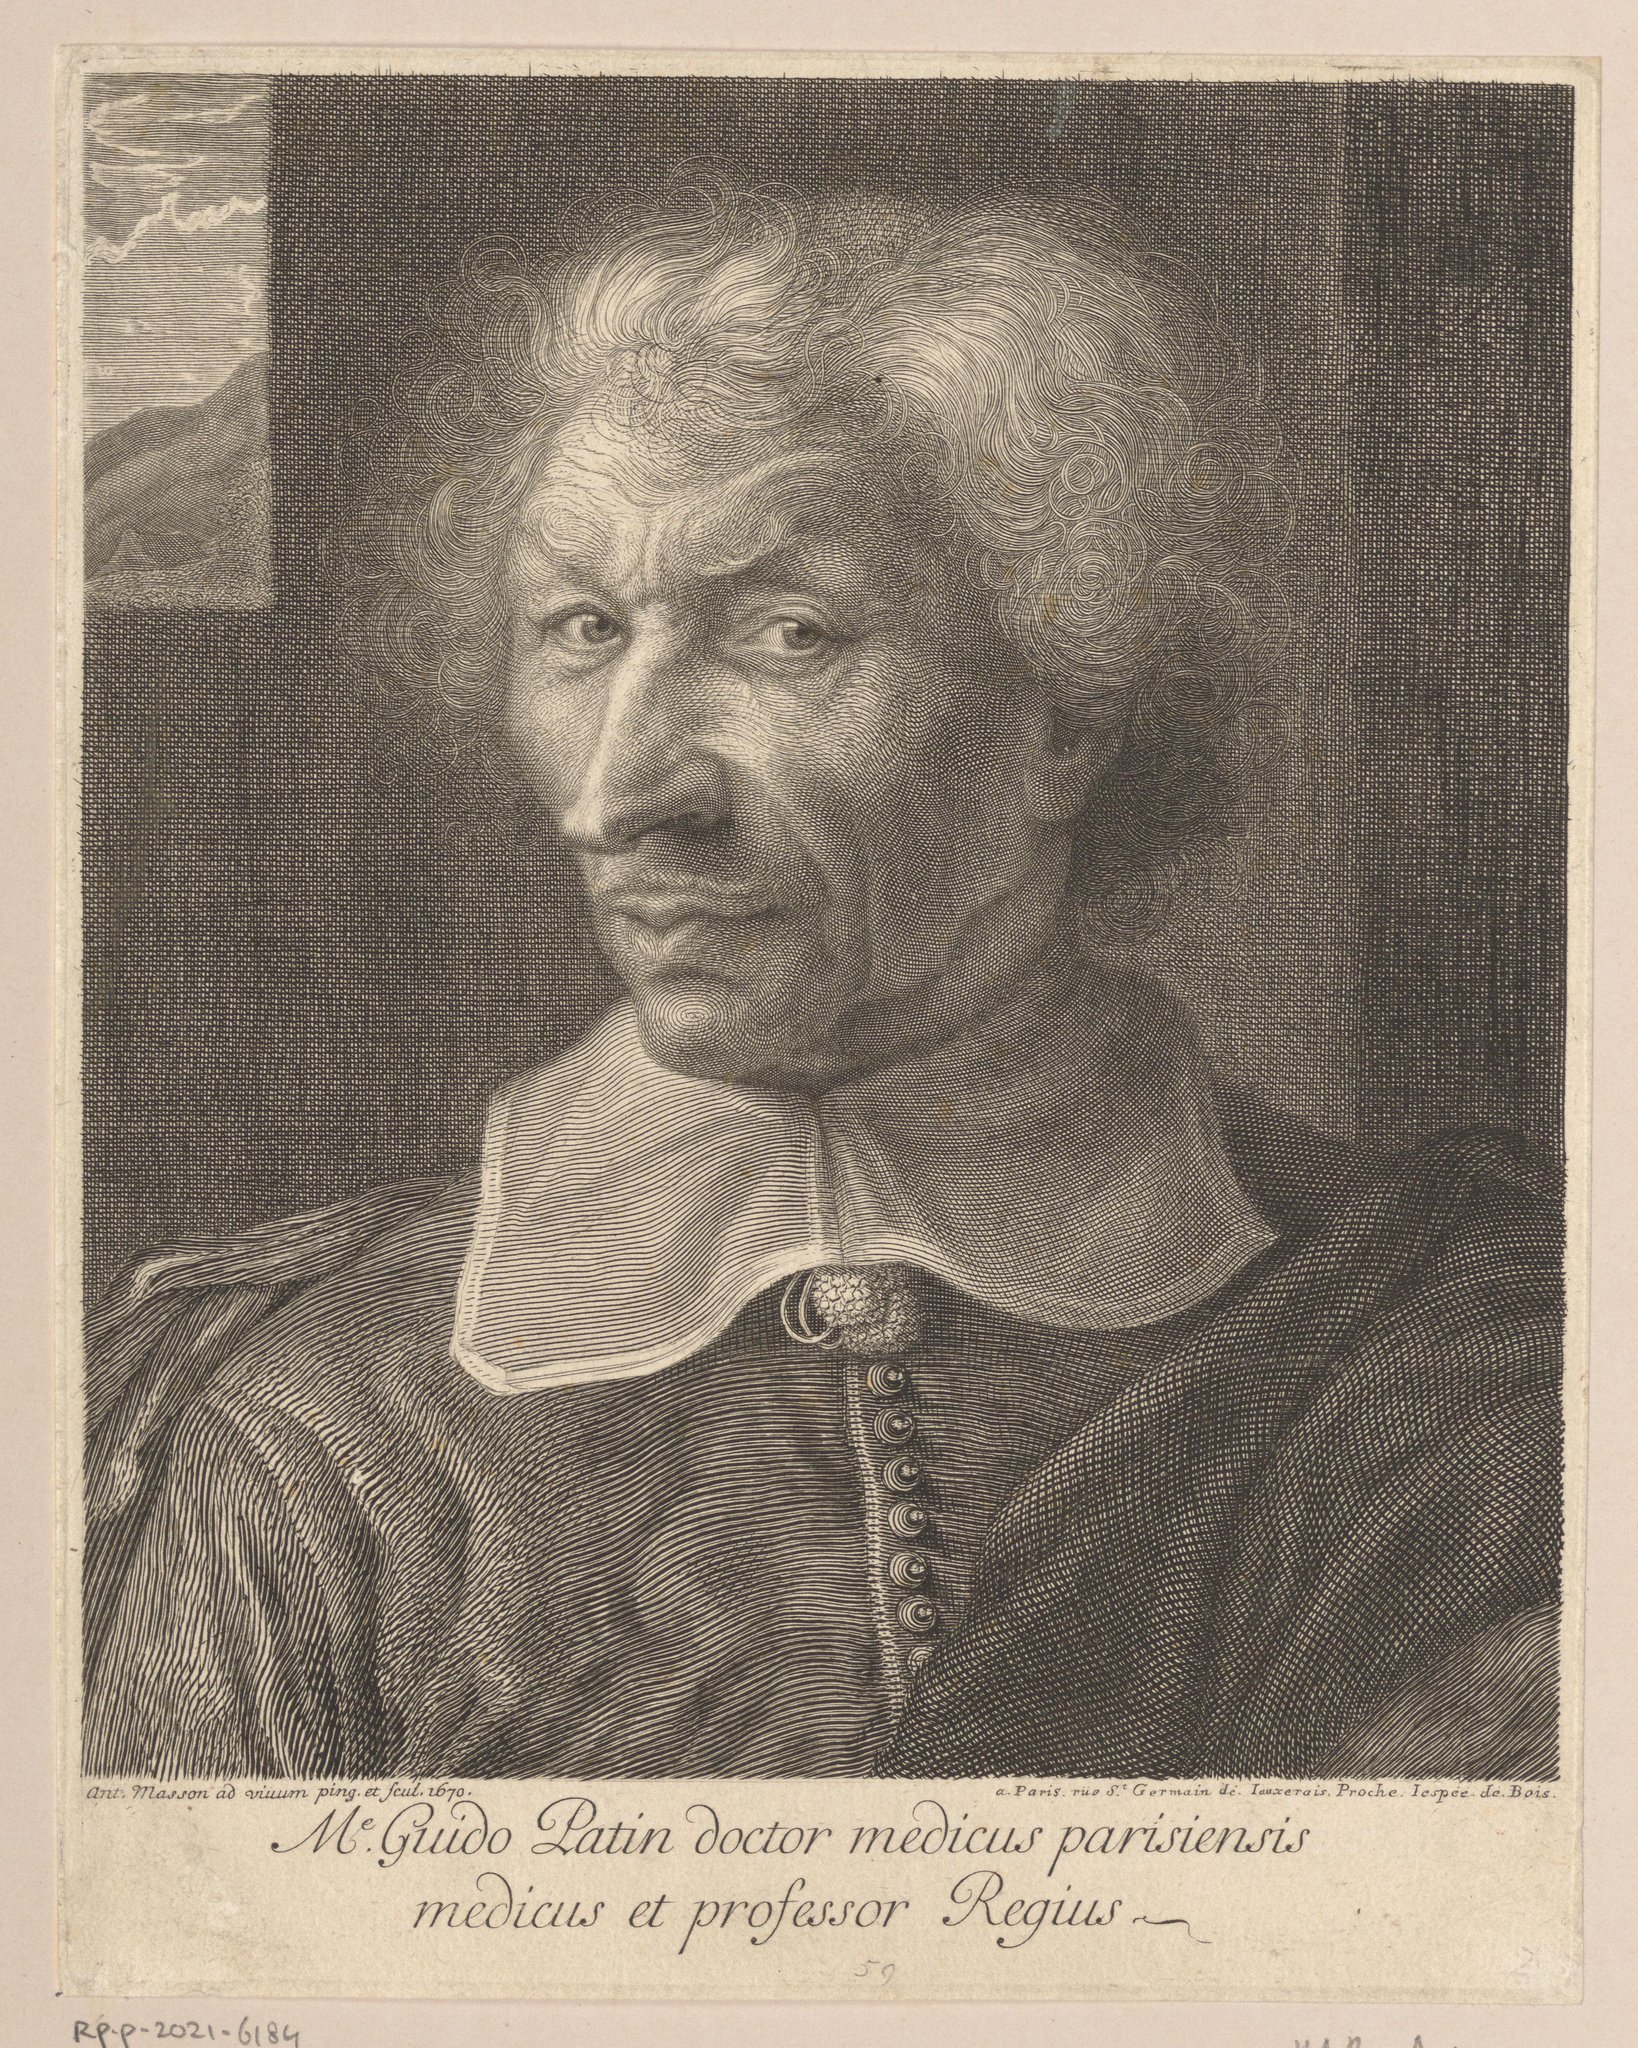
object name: print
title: Portret van Guy Patin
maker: antoine masson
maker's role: print maker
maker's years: 1636-1700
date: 1670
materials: paper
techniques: engraving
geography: paris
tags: paris, adult man, historical persons, physician, doctor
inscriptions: collector's mark: Lugt 240